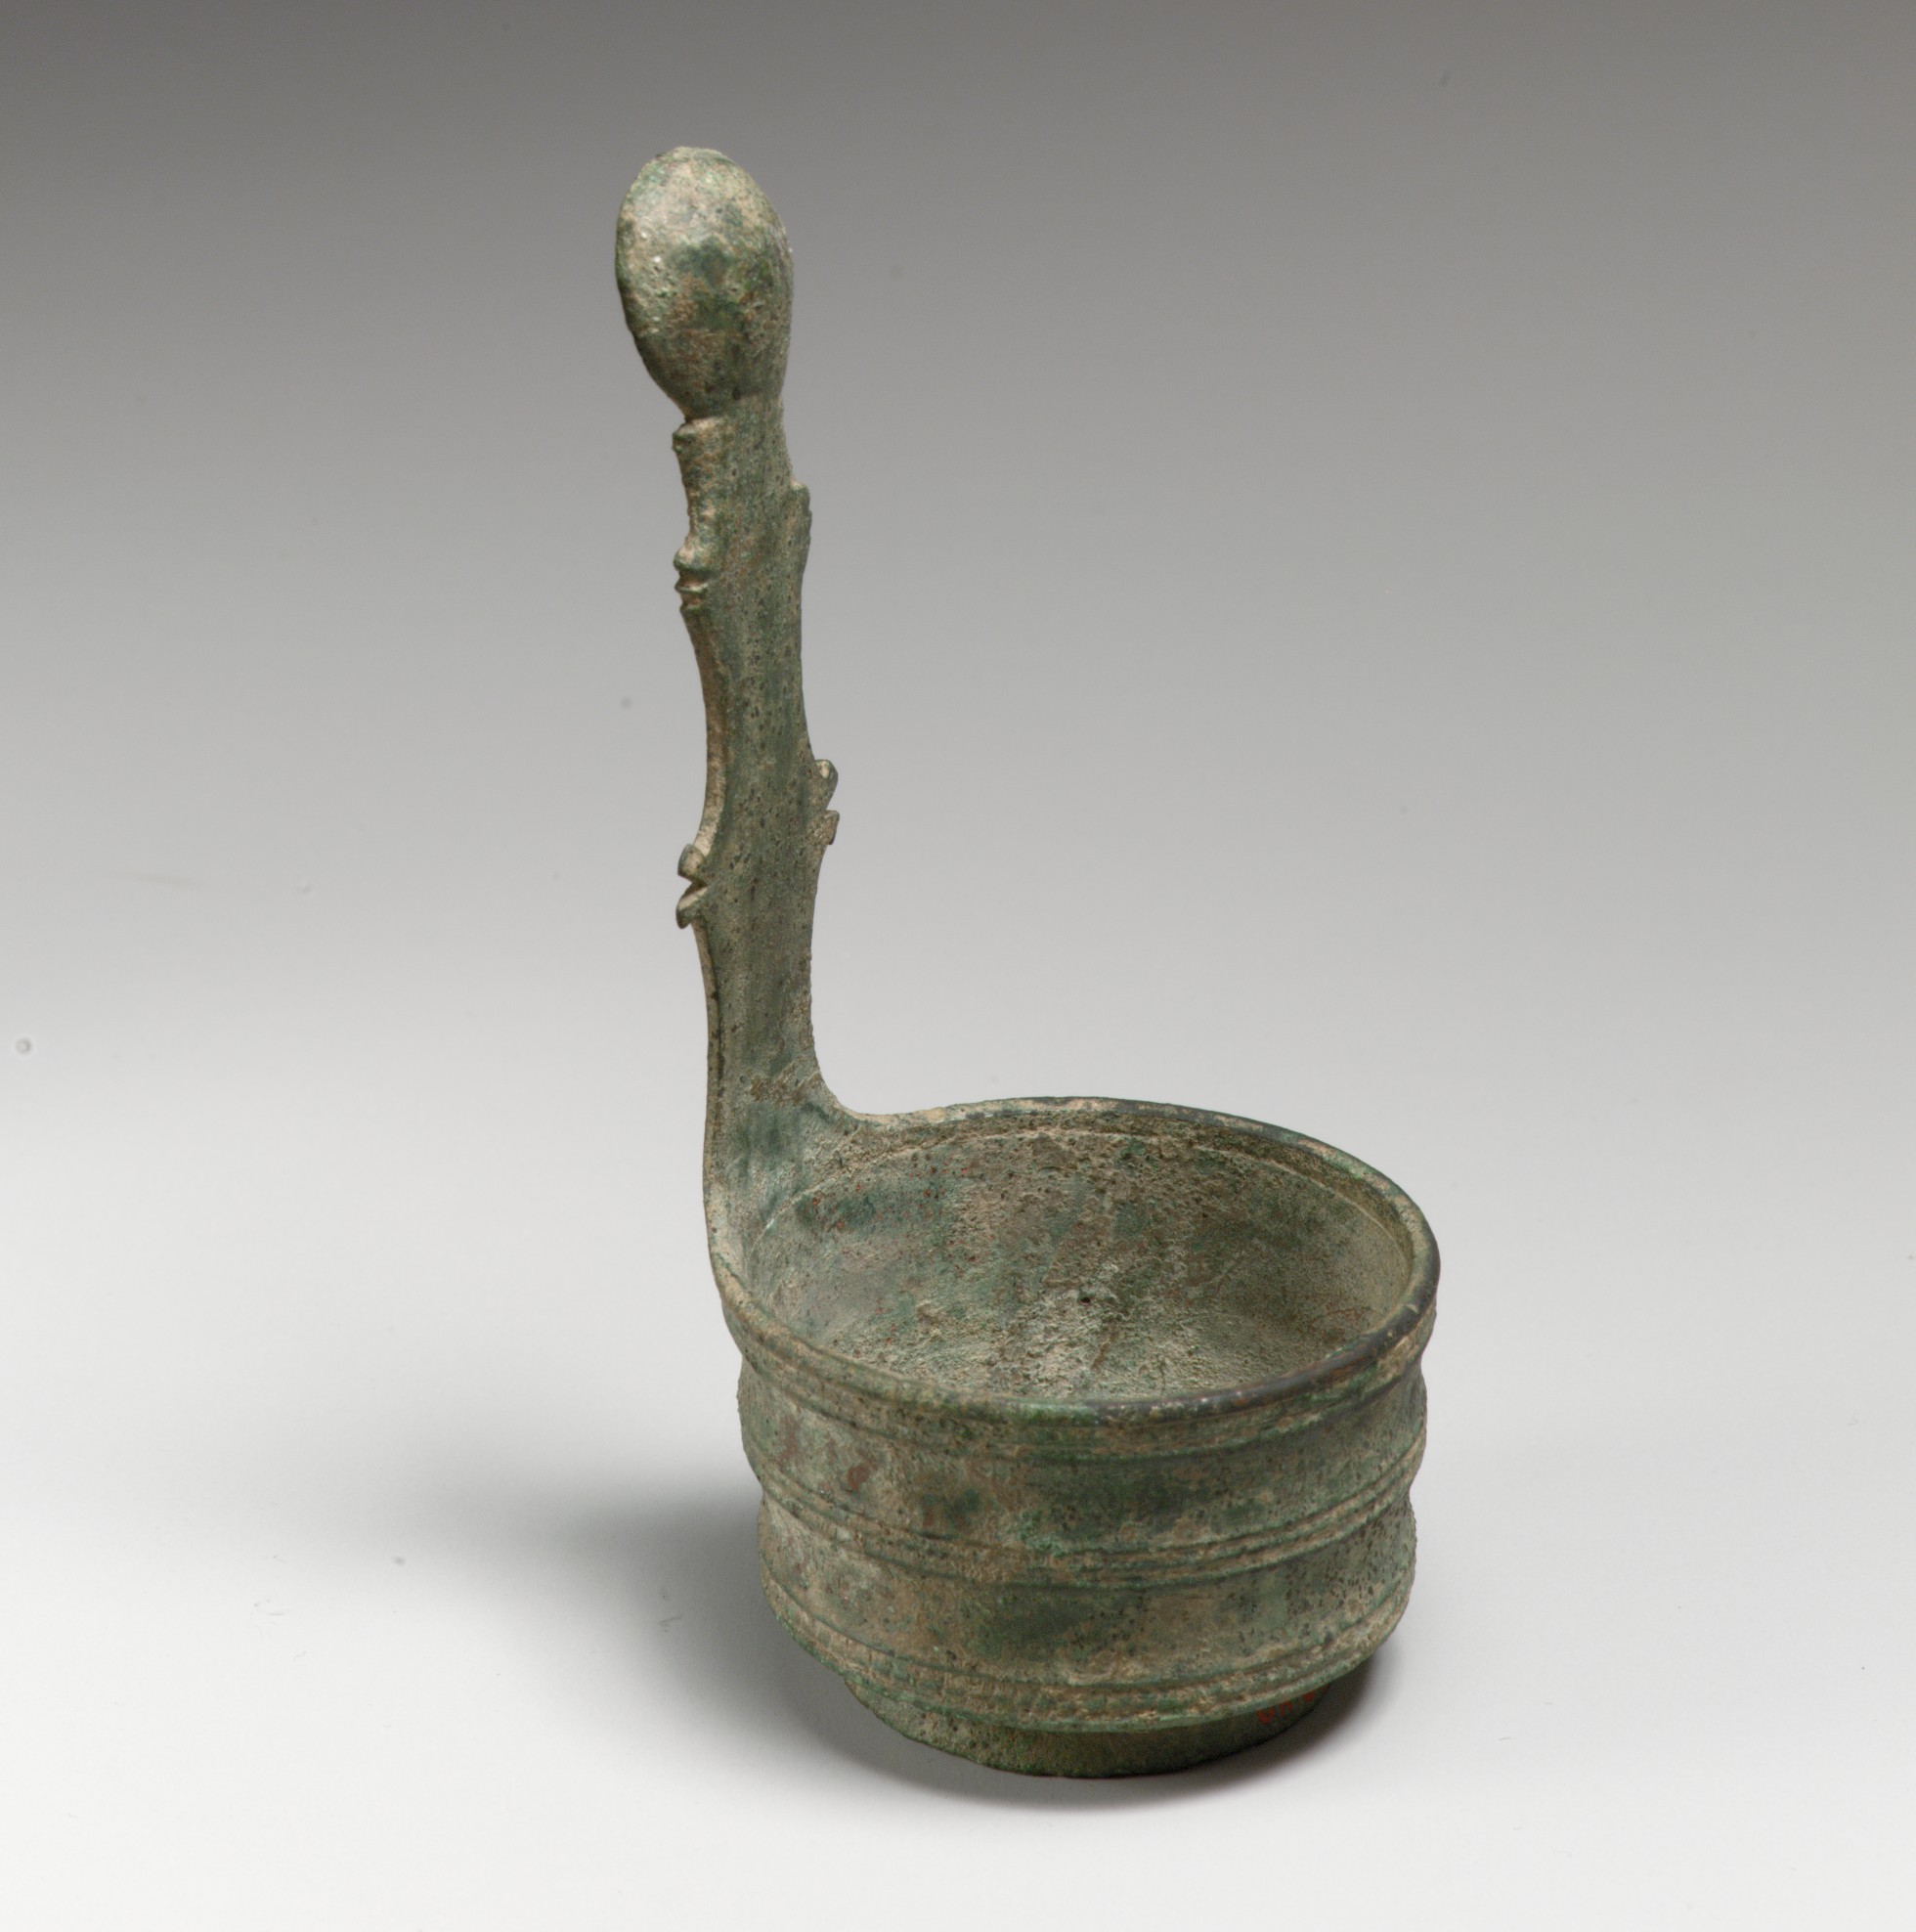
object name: ladle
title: Bronze simpulum (ladle)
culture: roman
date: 67-133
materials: bronze